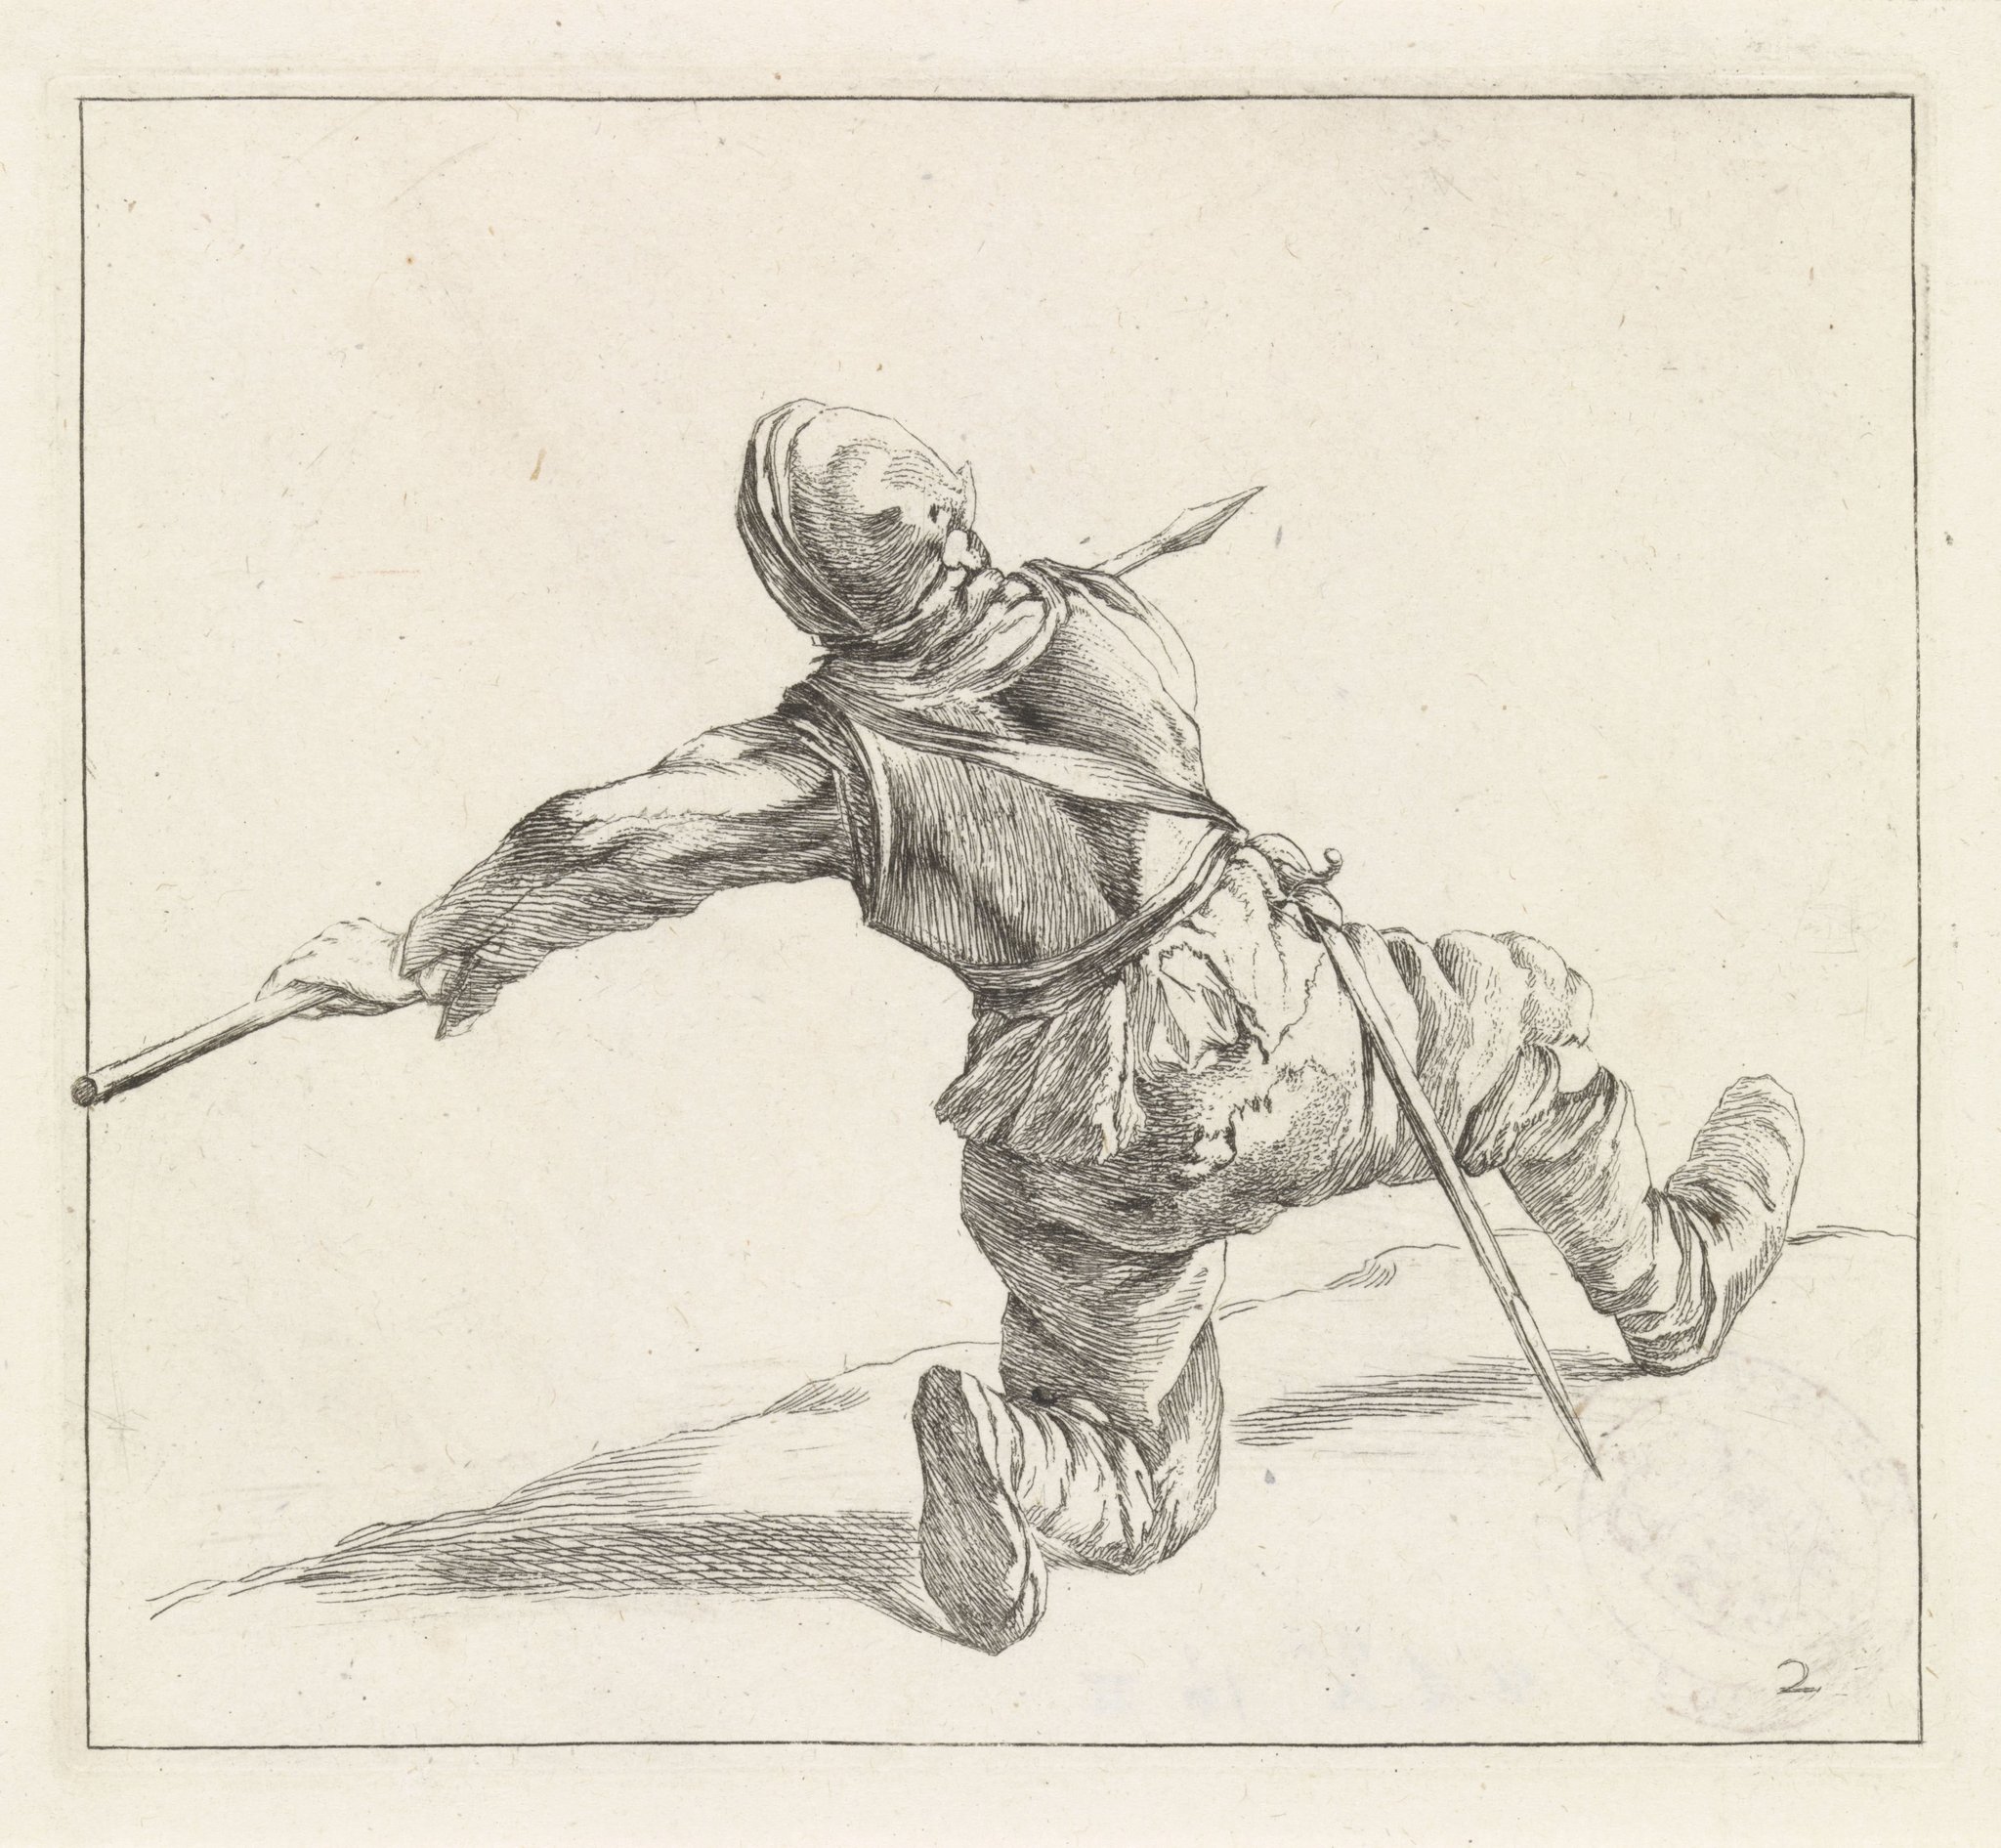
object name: print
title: Soldats & Chevaux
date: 1710-1717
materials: paper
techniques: etching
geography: amsterdam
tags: the soldier; the soldier's life (+ weapons), handling of weapons ~ military training, helved weapons, polearms (for striking, hacking, thrusting): lance, kneeling figure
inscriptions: collector's mark: Lugt 240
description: Geknielde piekenier met lans, op de rug gezien. Tweede prent uit een serie van twaalf prenten met voorstellingen van soldaten en paarden.